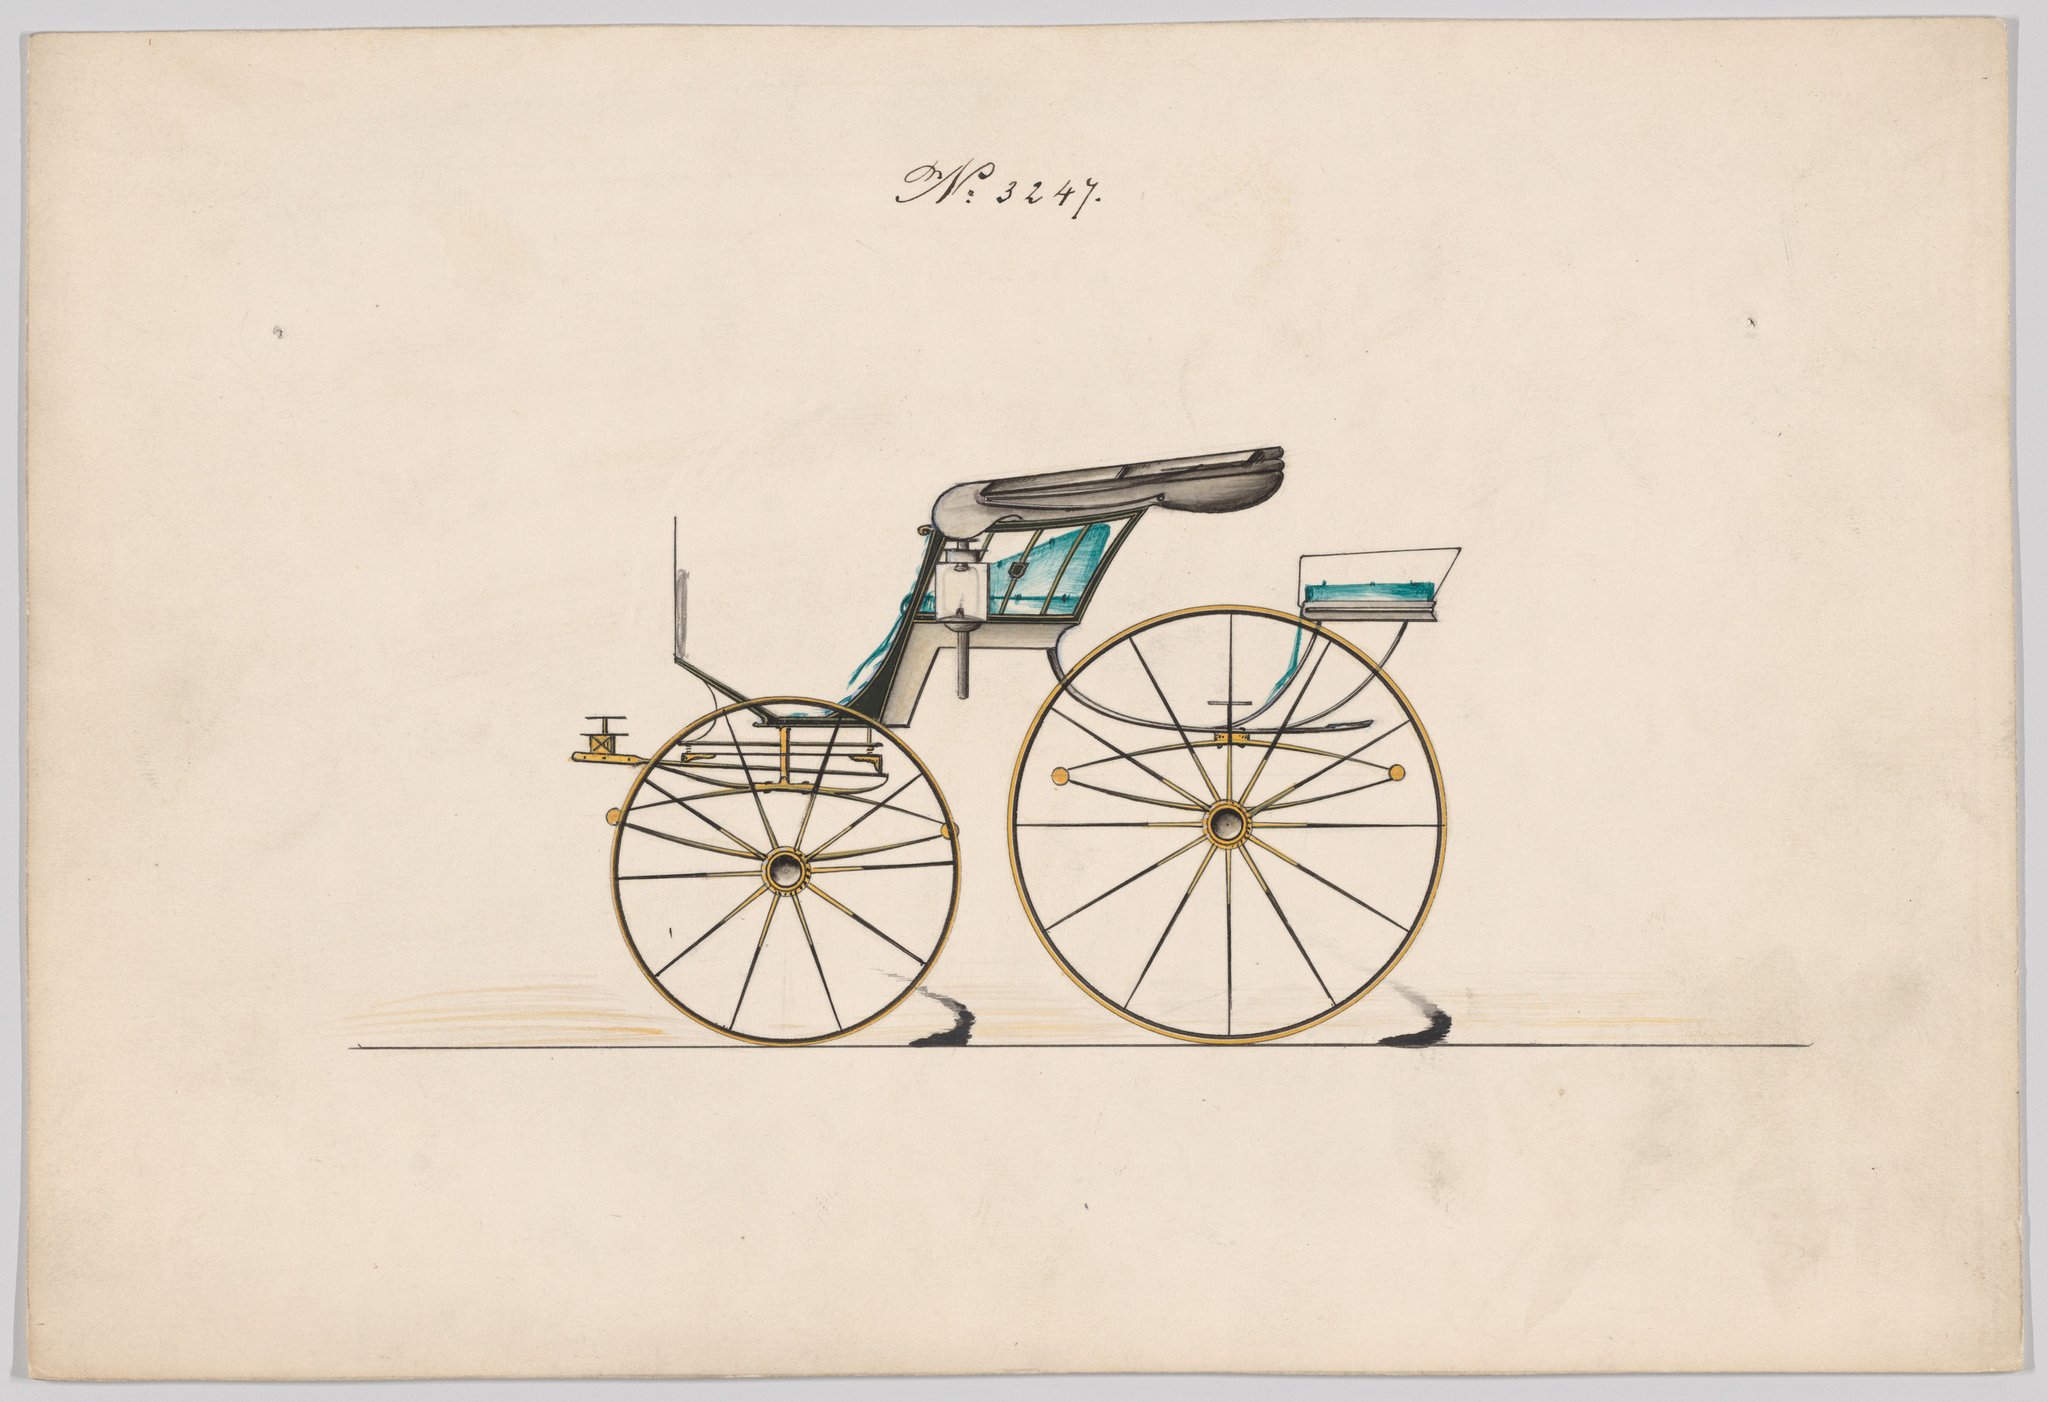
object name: drawing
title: Design for Pony Phaeton, no. 3247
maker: brewster & co.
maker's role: manufacturer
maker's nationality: american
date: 1876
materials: gouache, gum arabic, ink, watercolor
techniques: pen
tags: carriages